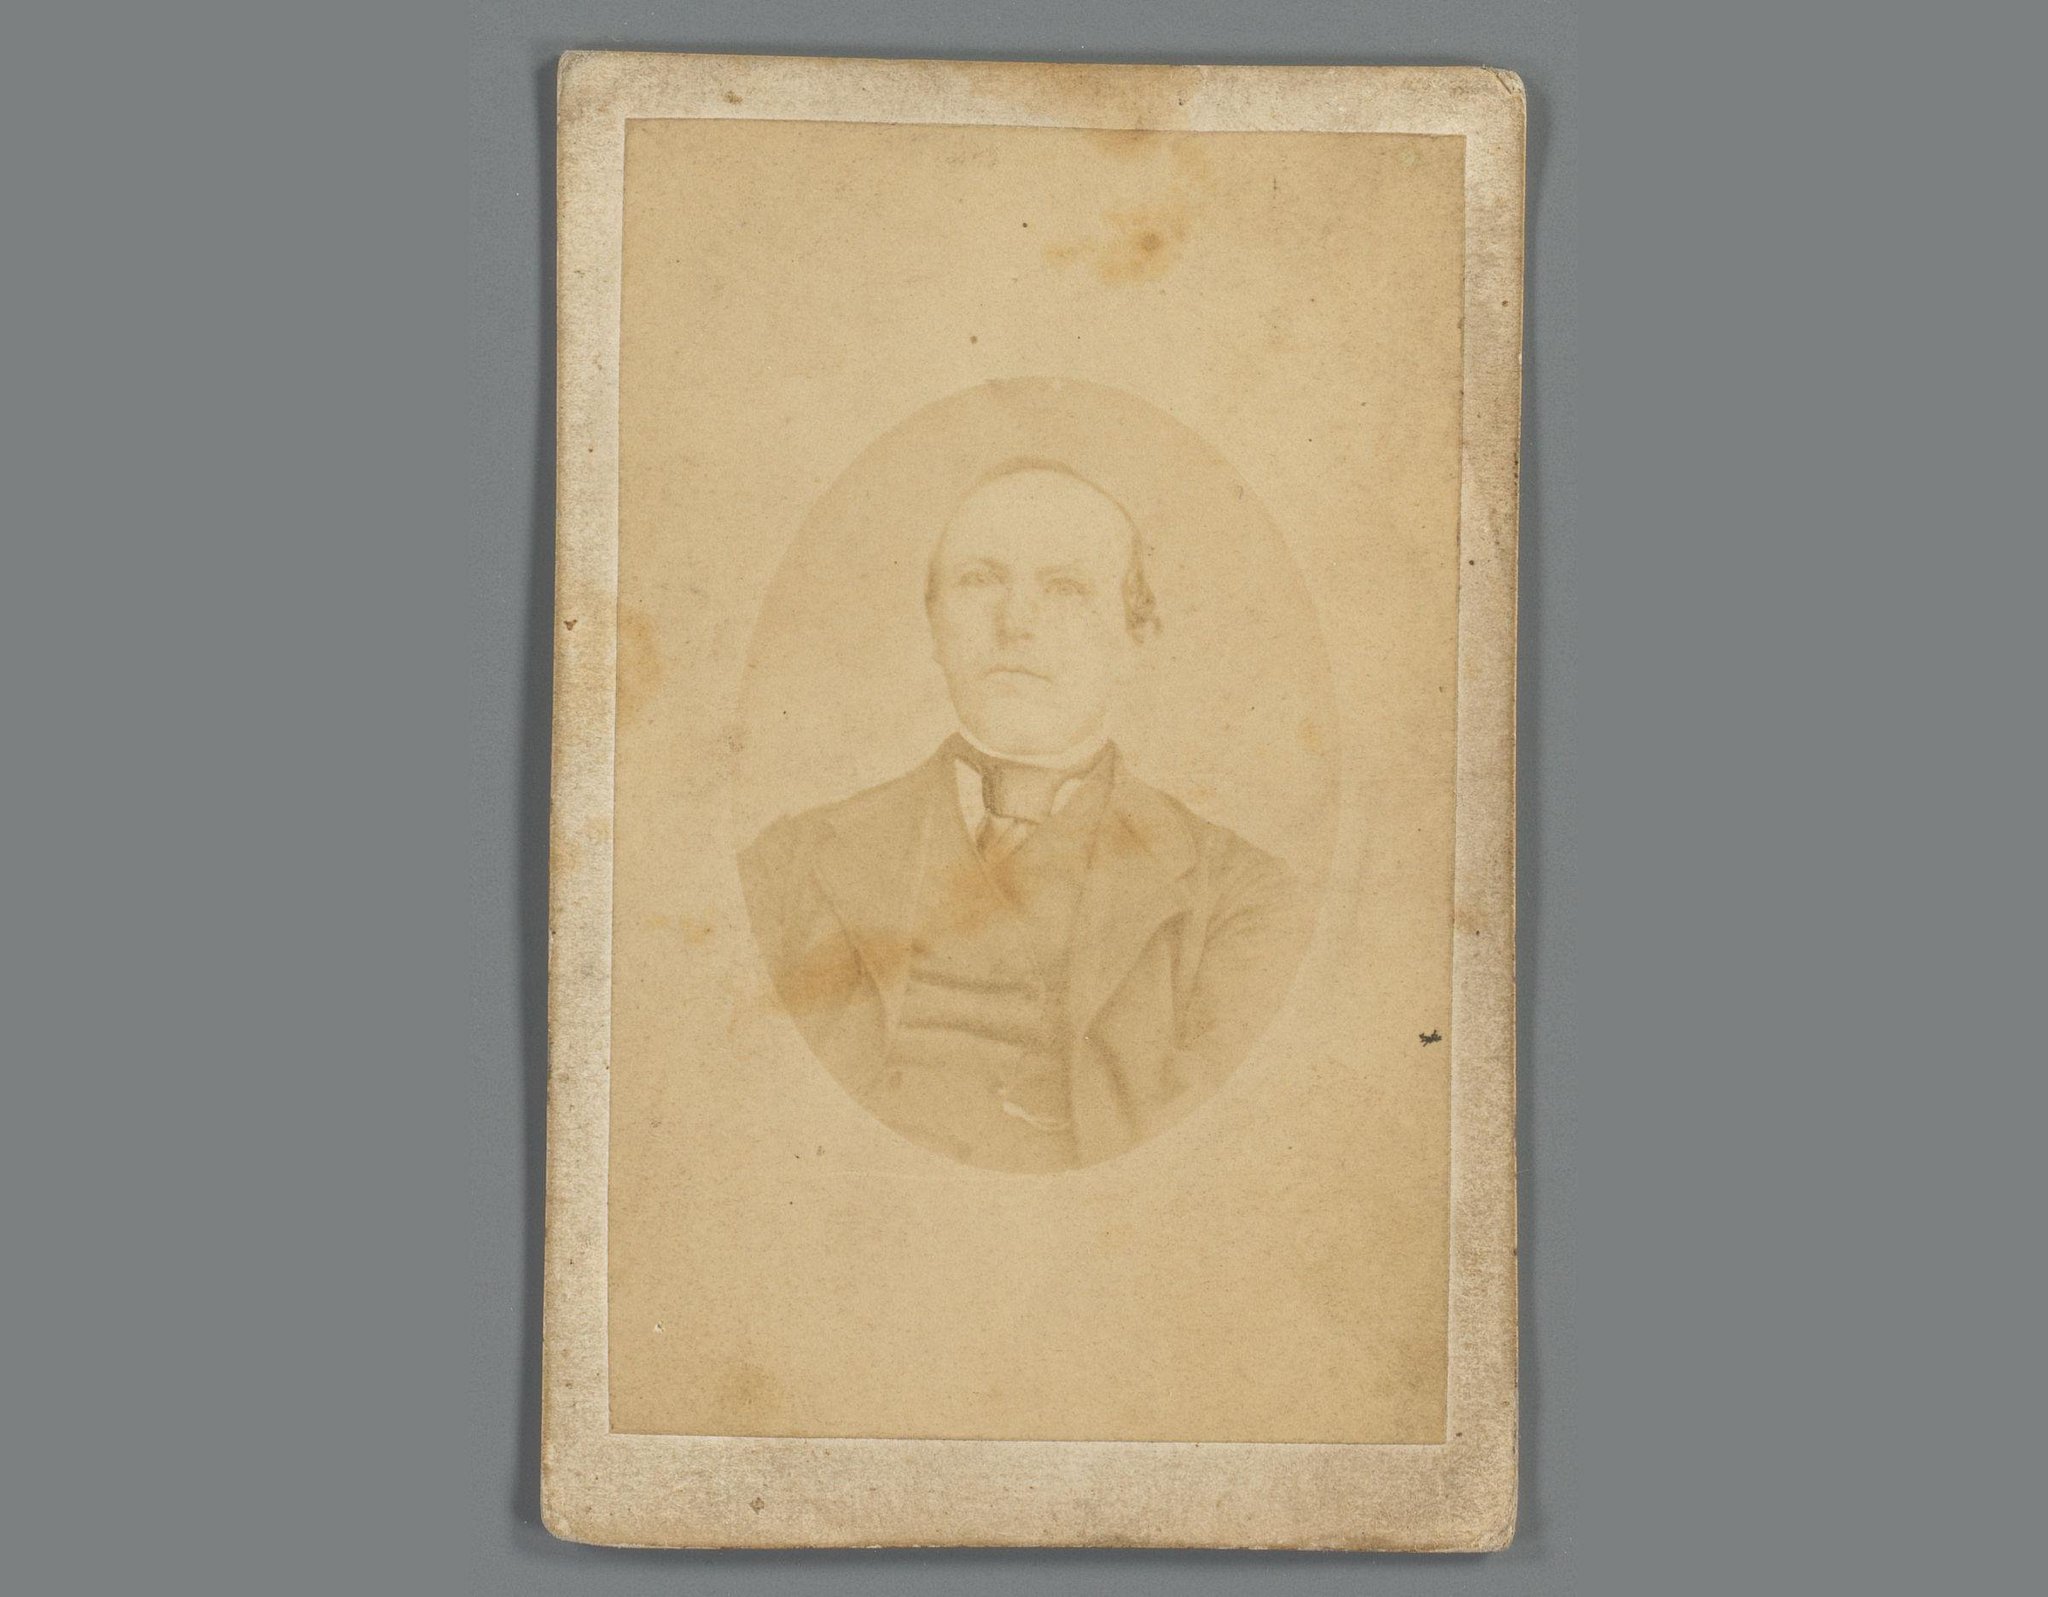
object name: prayer card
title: Portret van Joannis Verhees op bidprent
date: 1876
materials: cardboard, paper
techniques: albumen print, letterpress printing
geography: den bosch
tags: adult man, historical persons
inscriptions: inscription: ‘Bid voor de ziel van zaliger (...) Mijn Jezus barmhartigheid (100 dagen aflaat)./ W. van Gulick, 's-Bosch.’